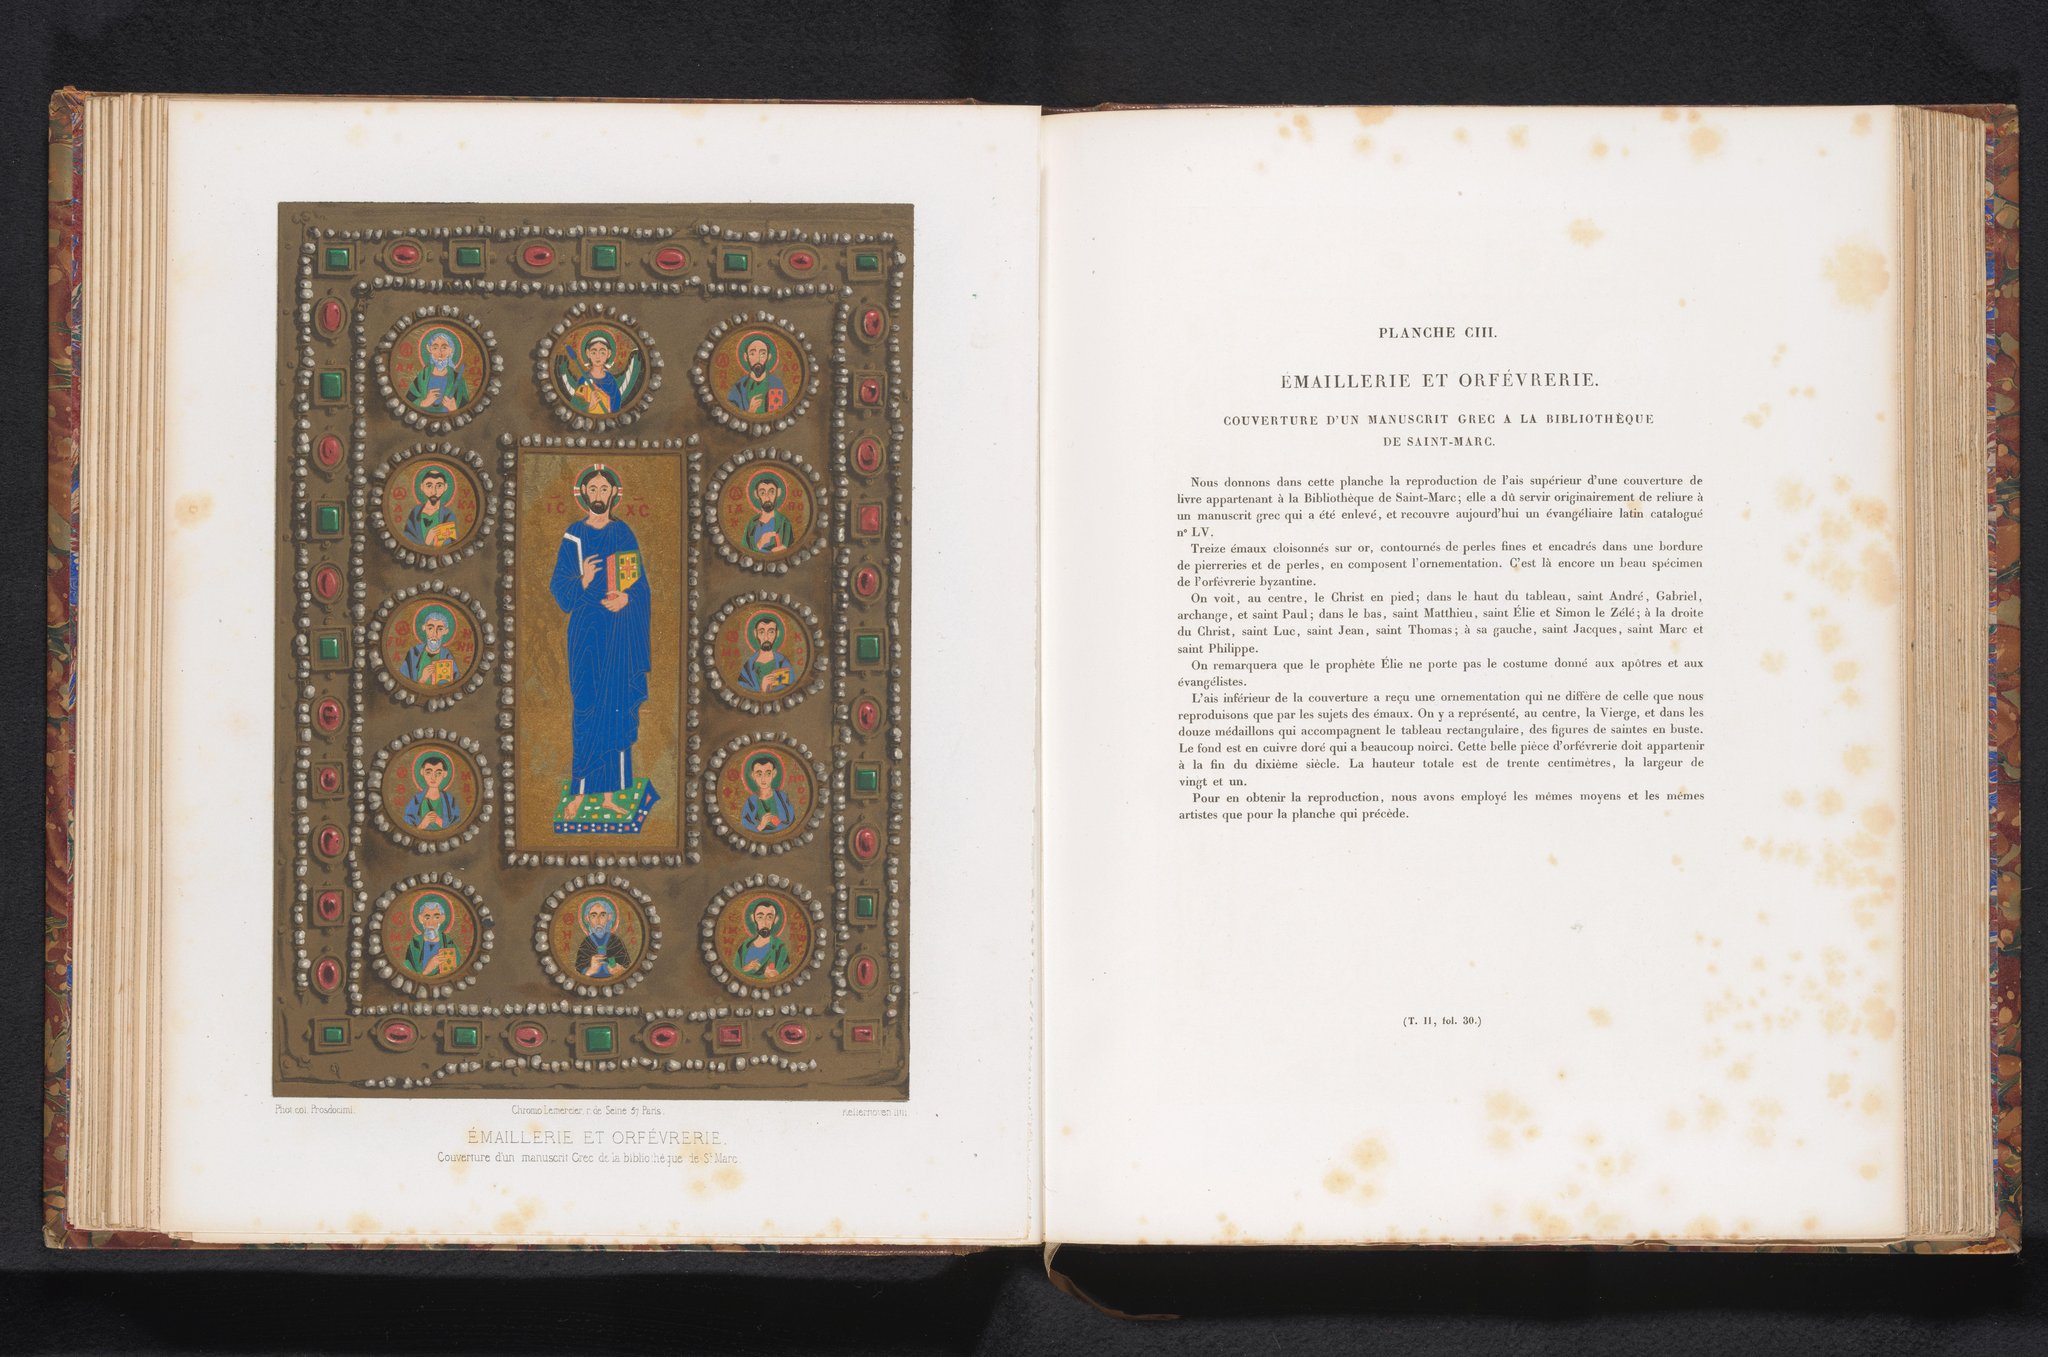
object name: page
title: Reproductie van een omslag van een Grieks manuscript met Christus, aartsengel Gabriël en enkele heiligen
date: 1859-1864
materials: paper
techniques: photolithography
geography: paris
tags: the archangel gabriel, christ, book-cover, binding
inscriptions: name: ‘Phot. col. Prosdocimi./ Kellerhoven lith.’